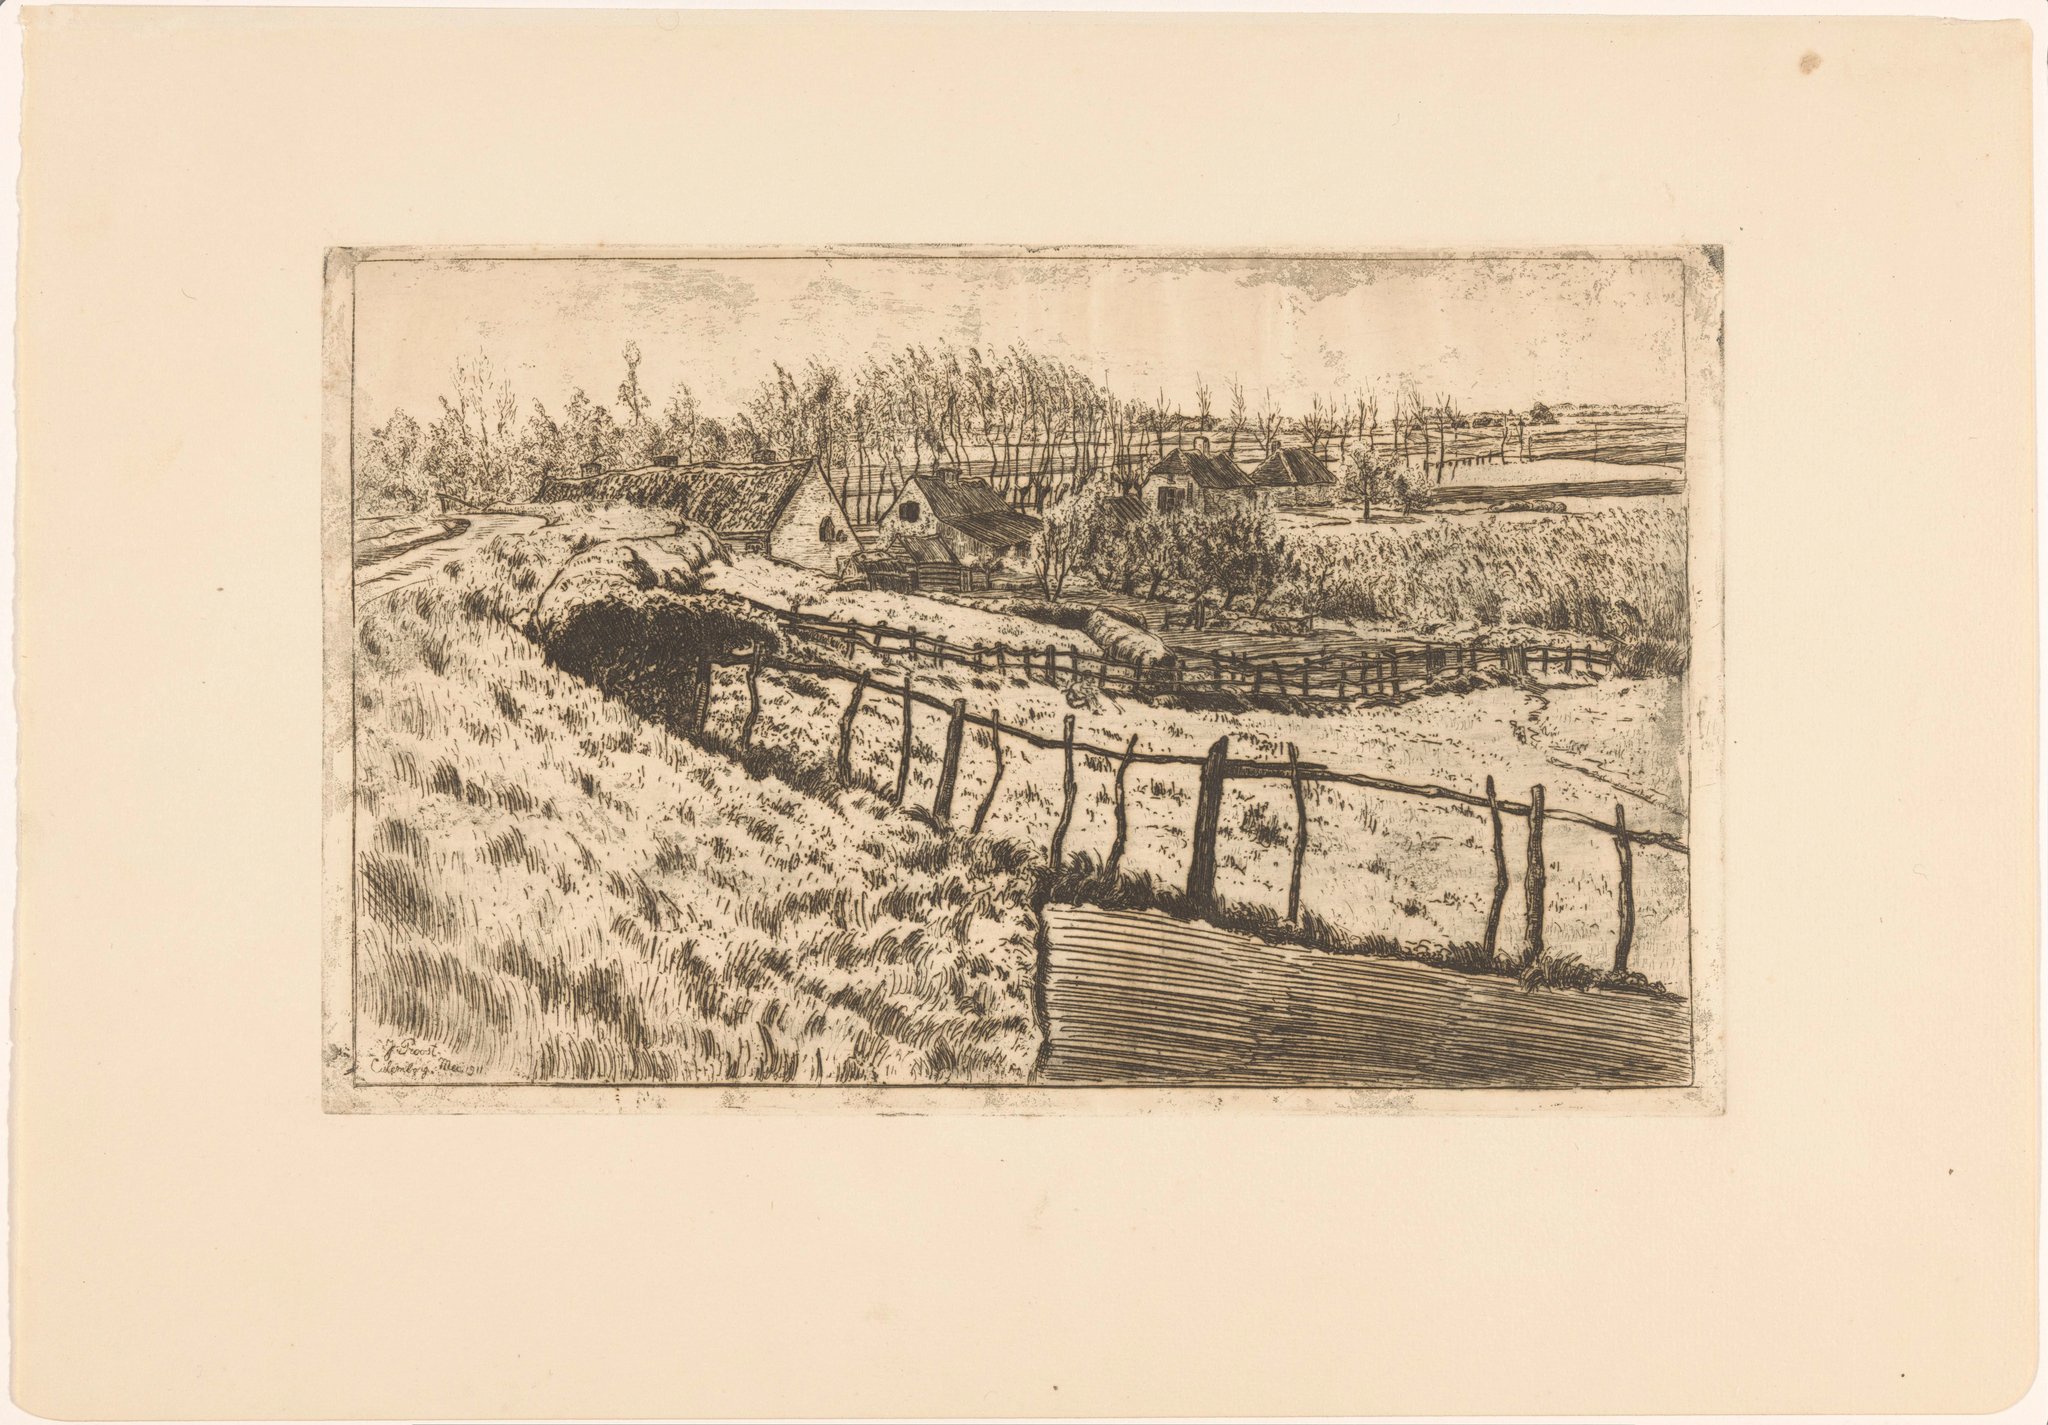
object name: print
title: Dijk bij Culemborg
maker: johannes proost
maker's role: print maker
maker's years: 1882-1942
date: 1905-1911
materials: paper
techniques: etching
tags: rural housing, e.g. country-house, villa, cottage, dikes, levee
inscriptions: collector's mark: Lugt 2228